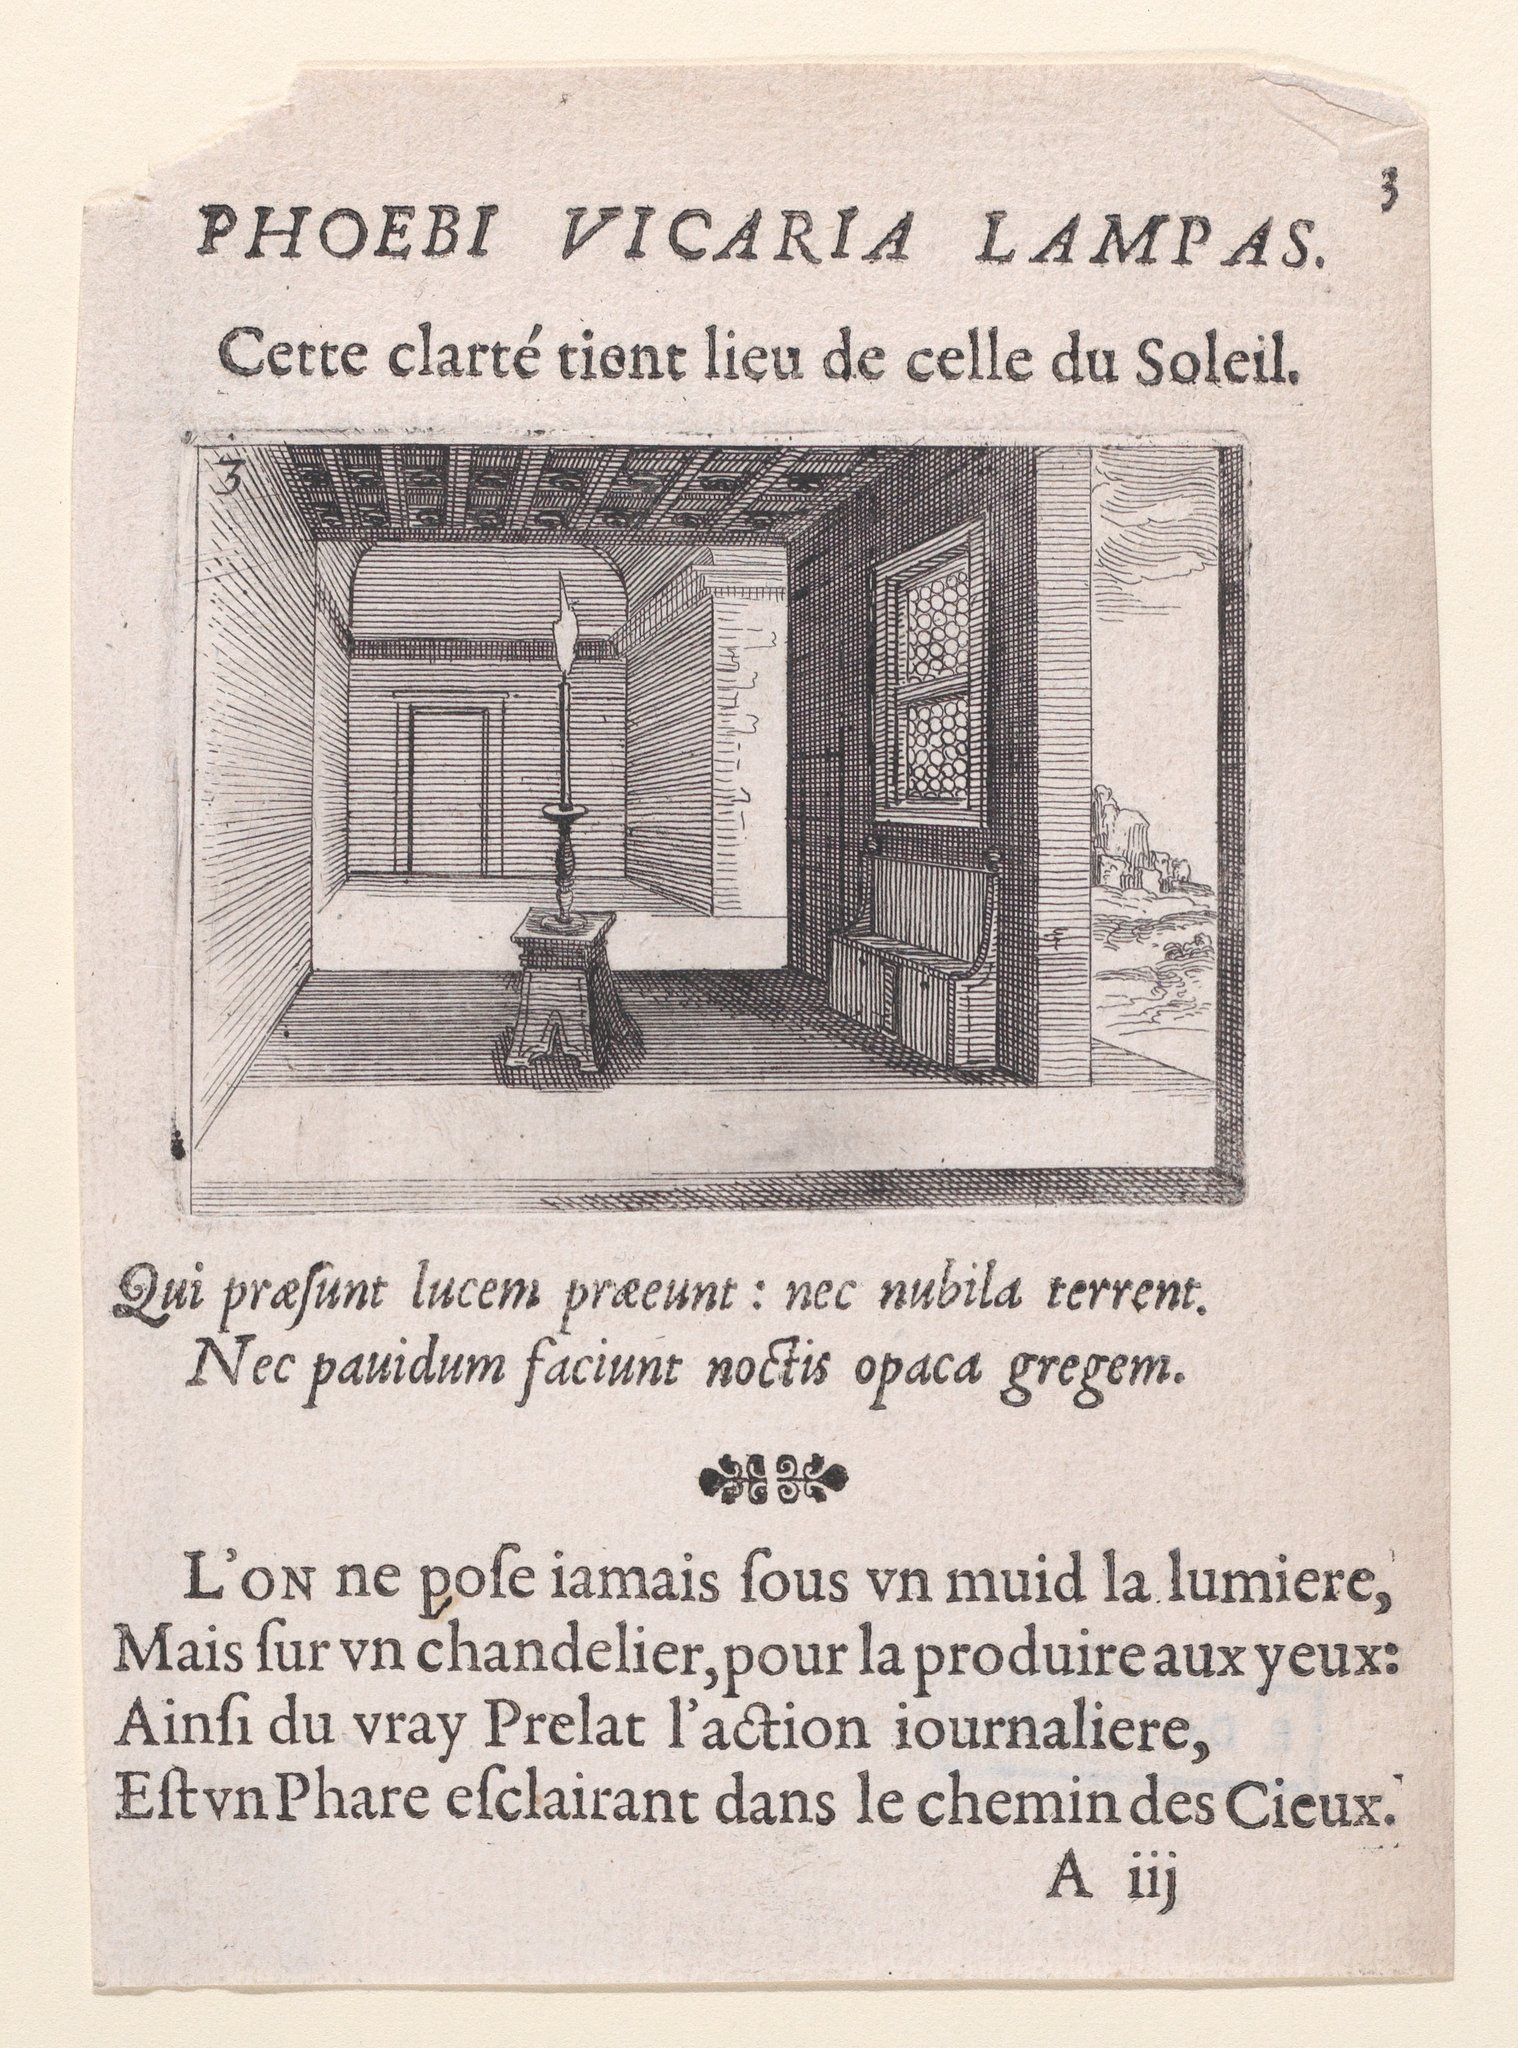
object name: print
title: Le Chandelier (The Candelabra), plate 3 from "Lux Claustri ou La Lumière du Cloitre" (The Light of the Cloisters)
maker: jacques callot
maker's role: artist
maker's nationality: french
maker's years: 1592-1635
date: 1625-1631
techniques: etching, letterpress